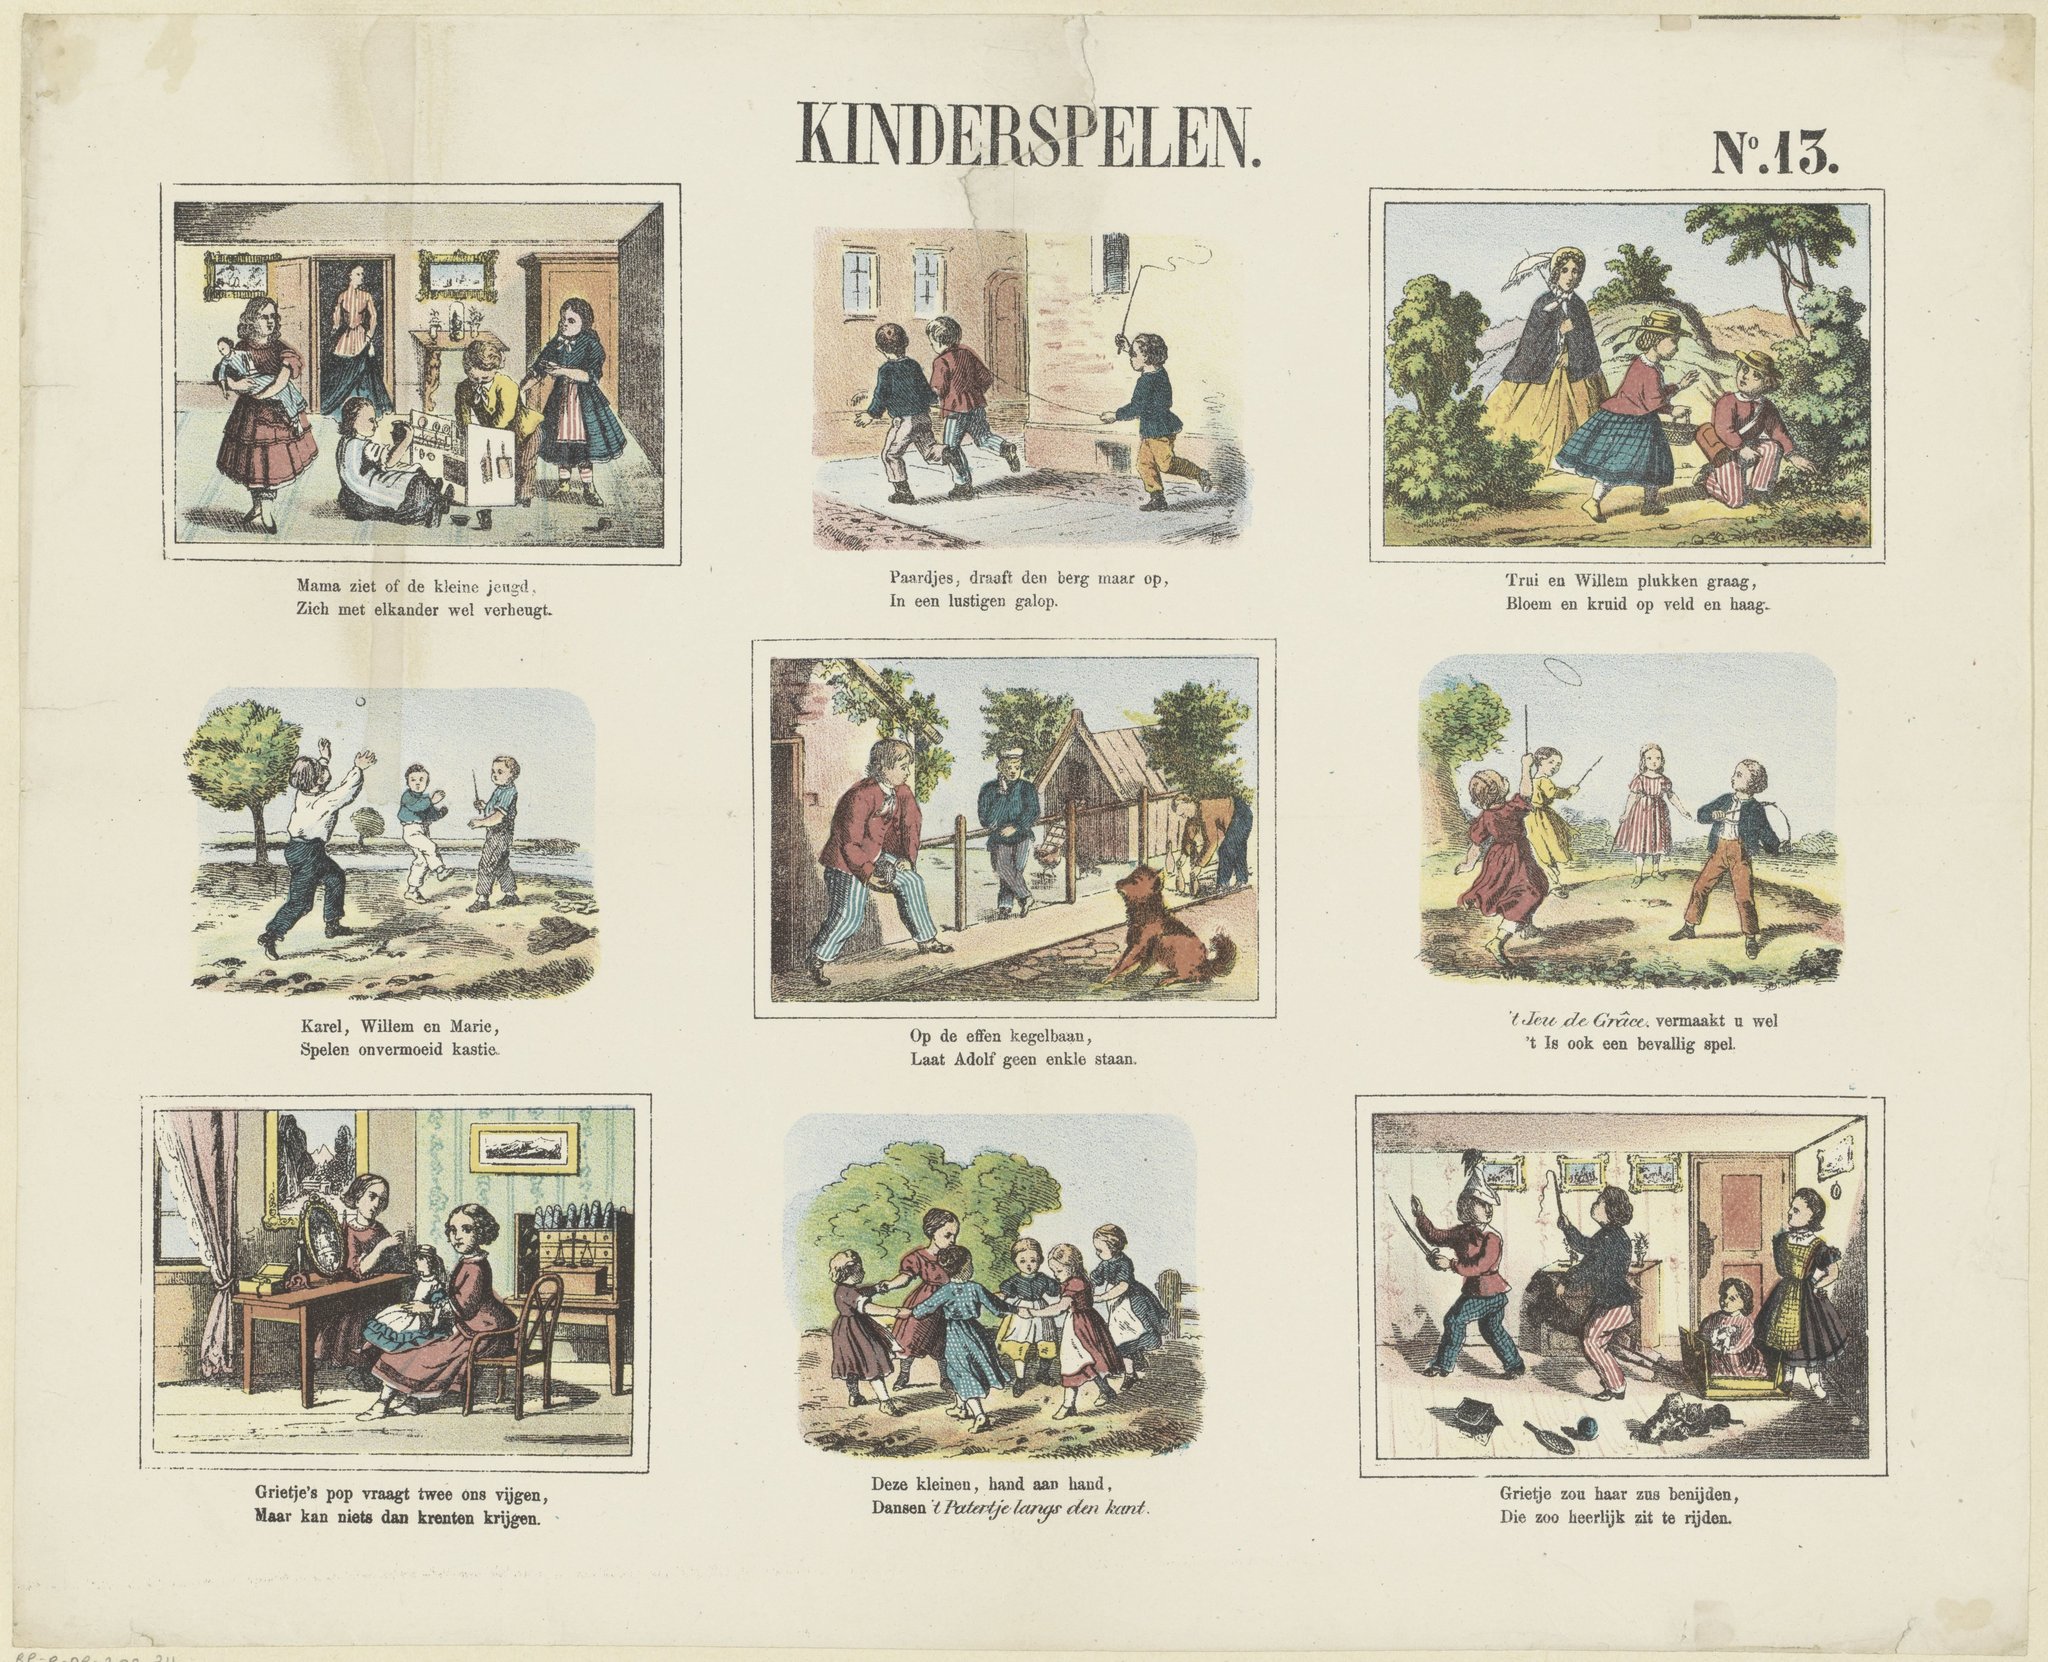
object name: popular print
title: Kinderspelen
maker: Anonymous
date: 1873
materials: paper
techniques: lithograph, letterpress printing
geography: amsterdam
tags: children's games and plays, dancing, (playing with) dolls, games using special objects (marbles, top, hoop, etc.)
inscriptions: collector's mark: Lugt 2760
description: Blad met 9 voorstellingen van kinderspelen, waaronder winkeltje spelen, paardje spelen, bloemen plukken, ballen, kegelen, hoepel vangen, met de pop spelen, rondedans en soldaatje spelen. Onder elke afbeelding een tweeregelig vers. Genummerd rechtsboven: No. 13.